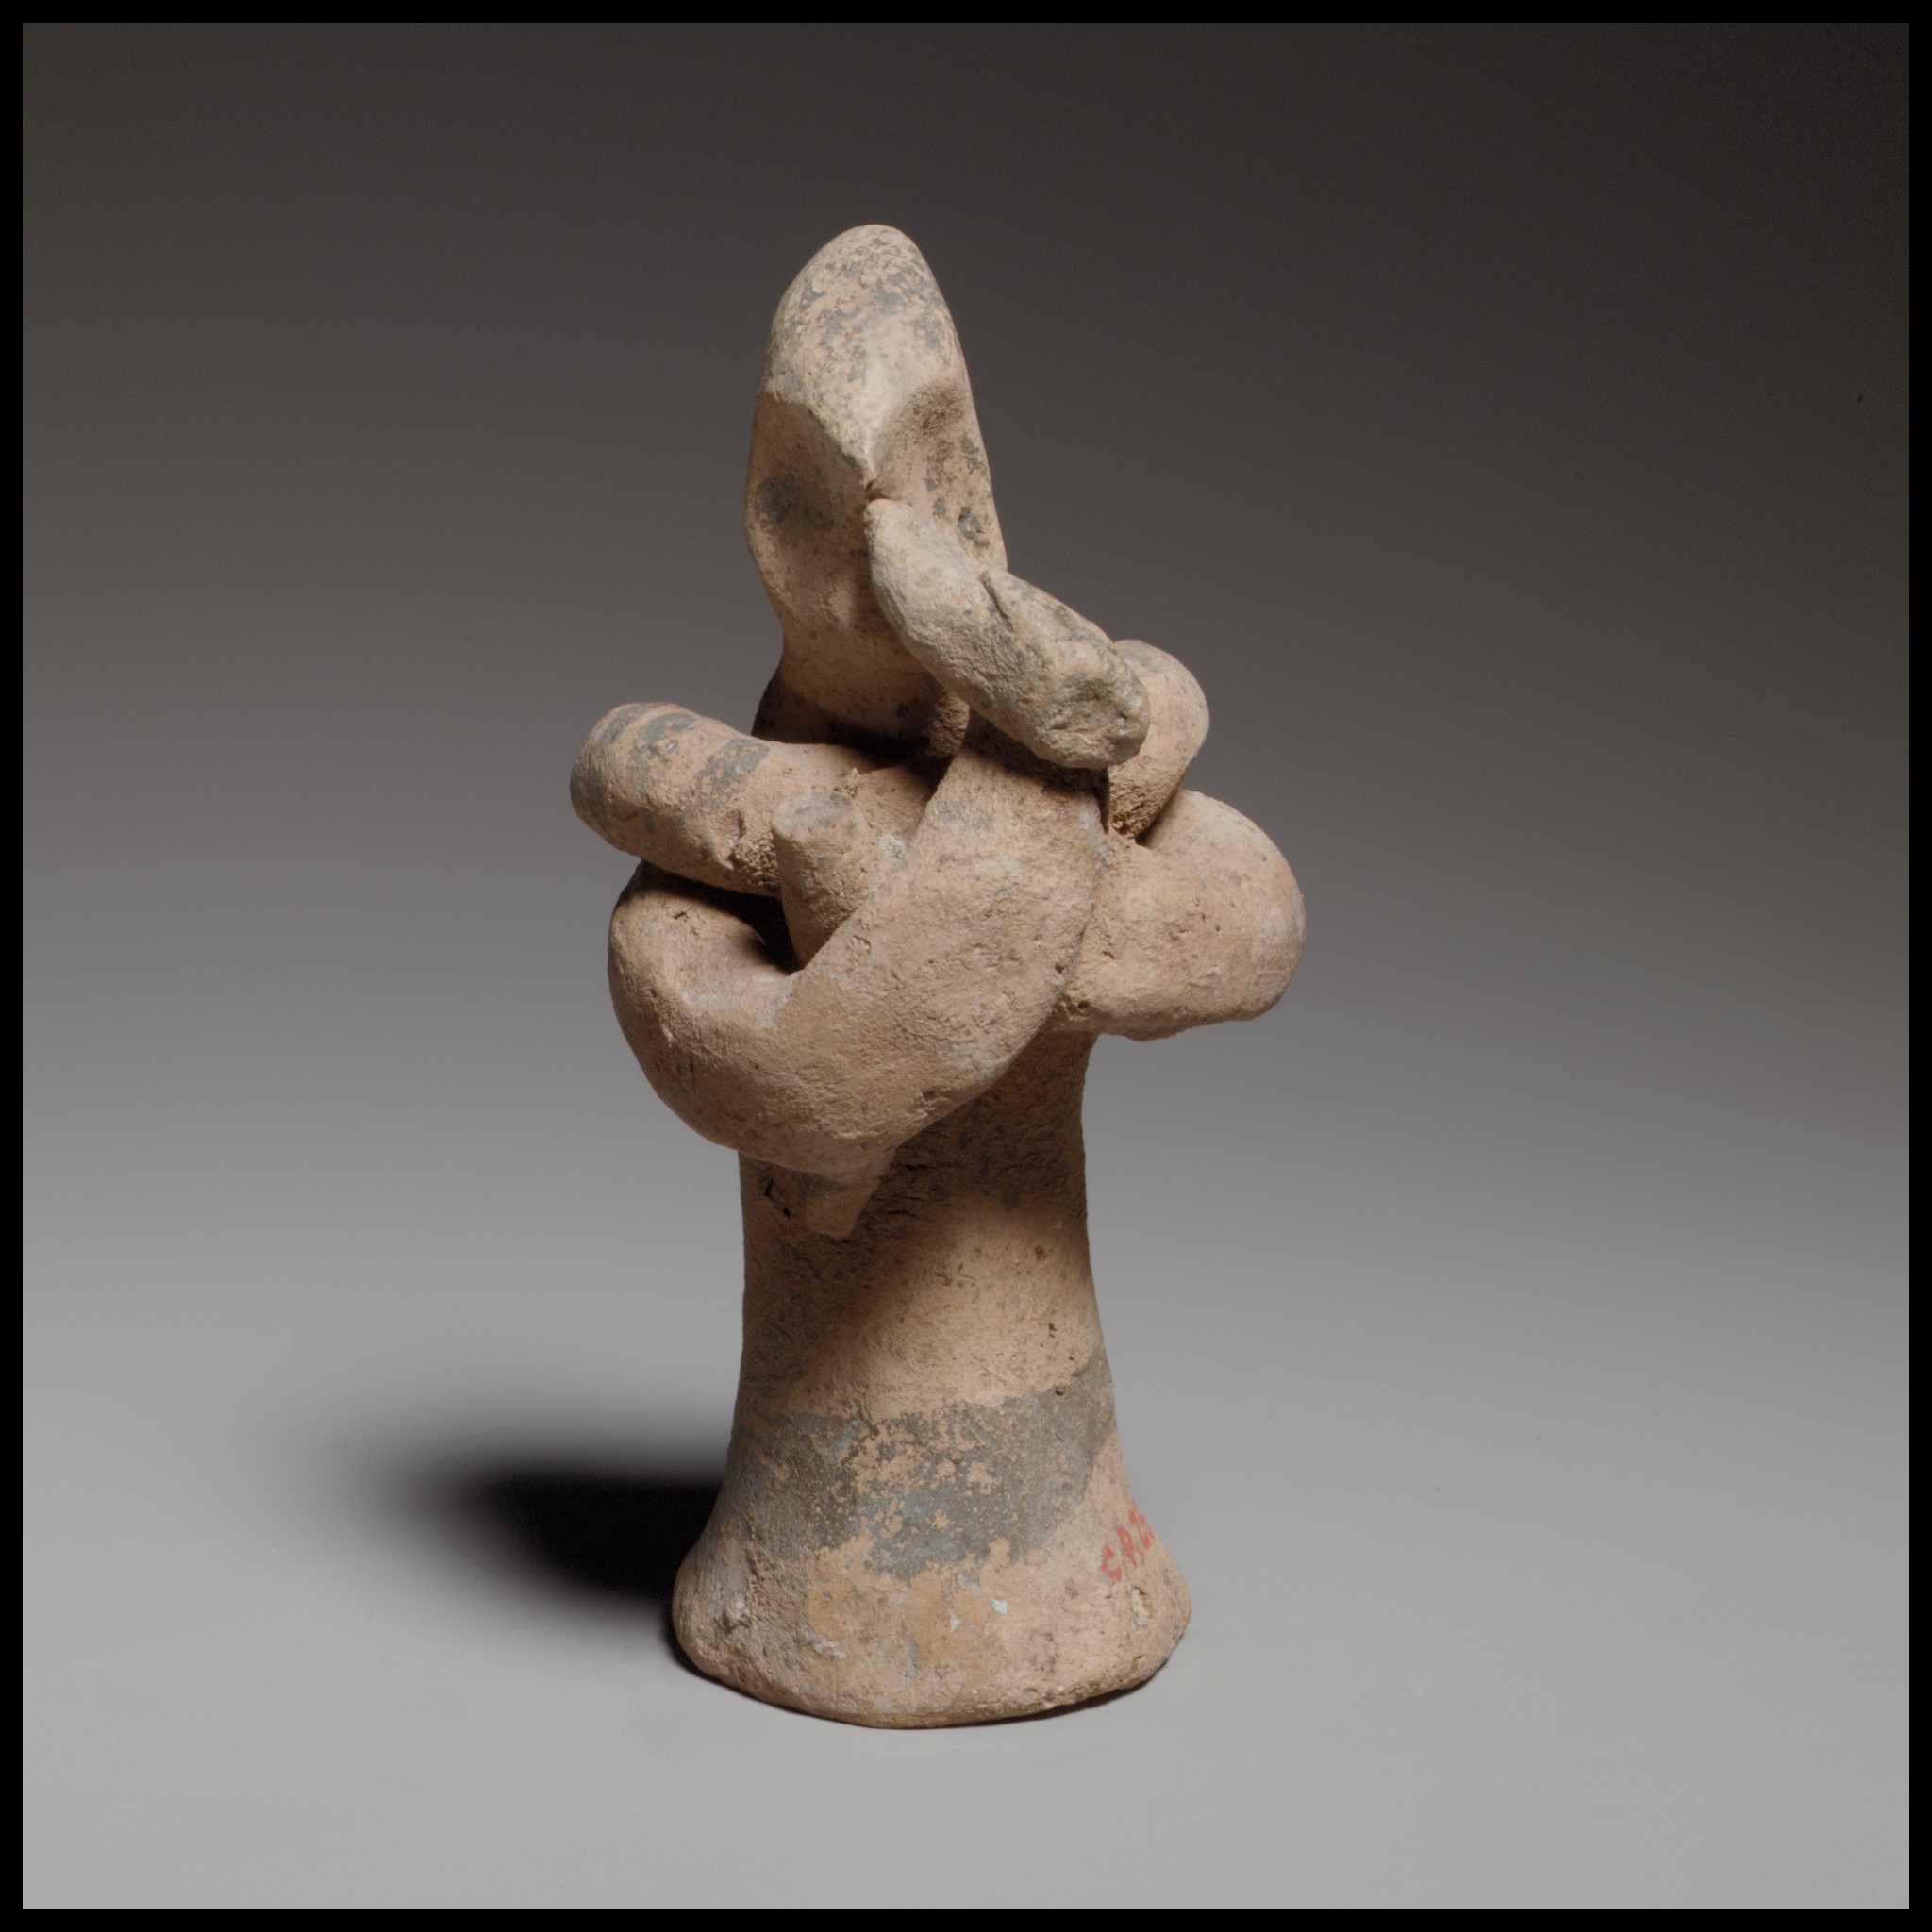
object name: statue of a man playing flute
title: Standing male flute player with a serpent around his shoulders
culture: cypriot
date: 750-600 BCE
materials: terracotta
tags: men,serpents,musicians